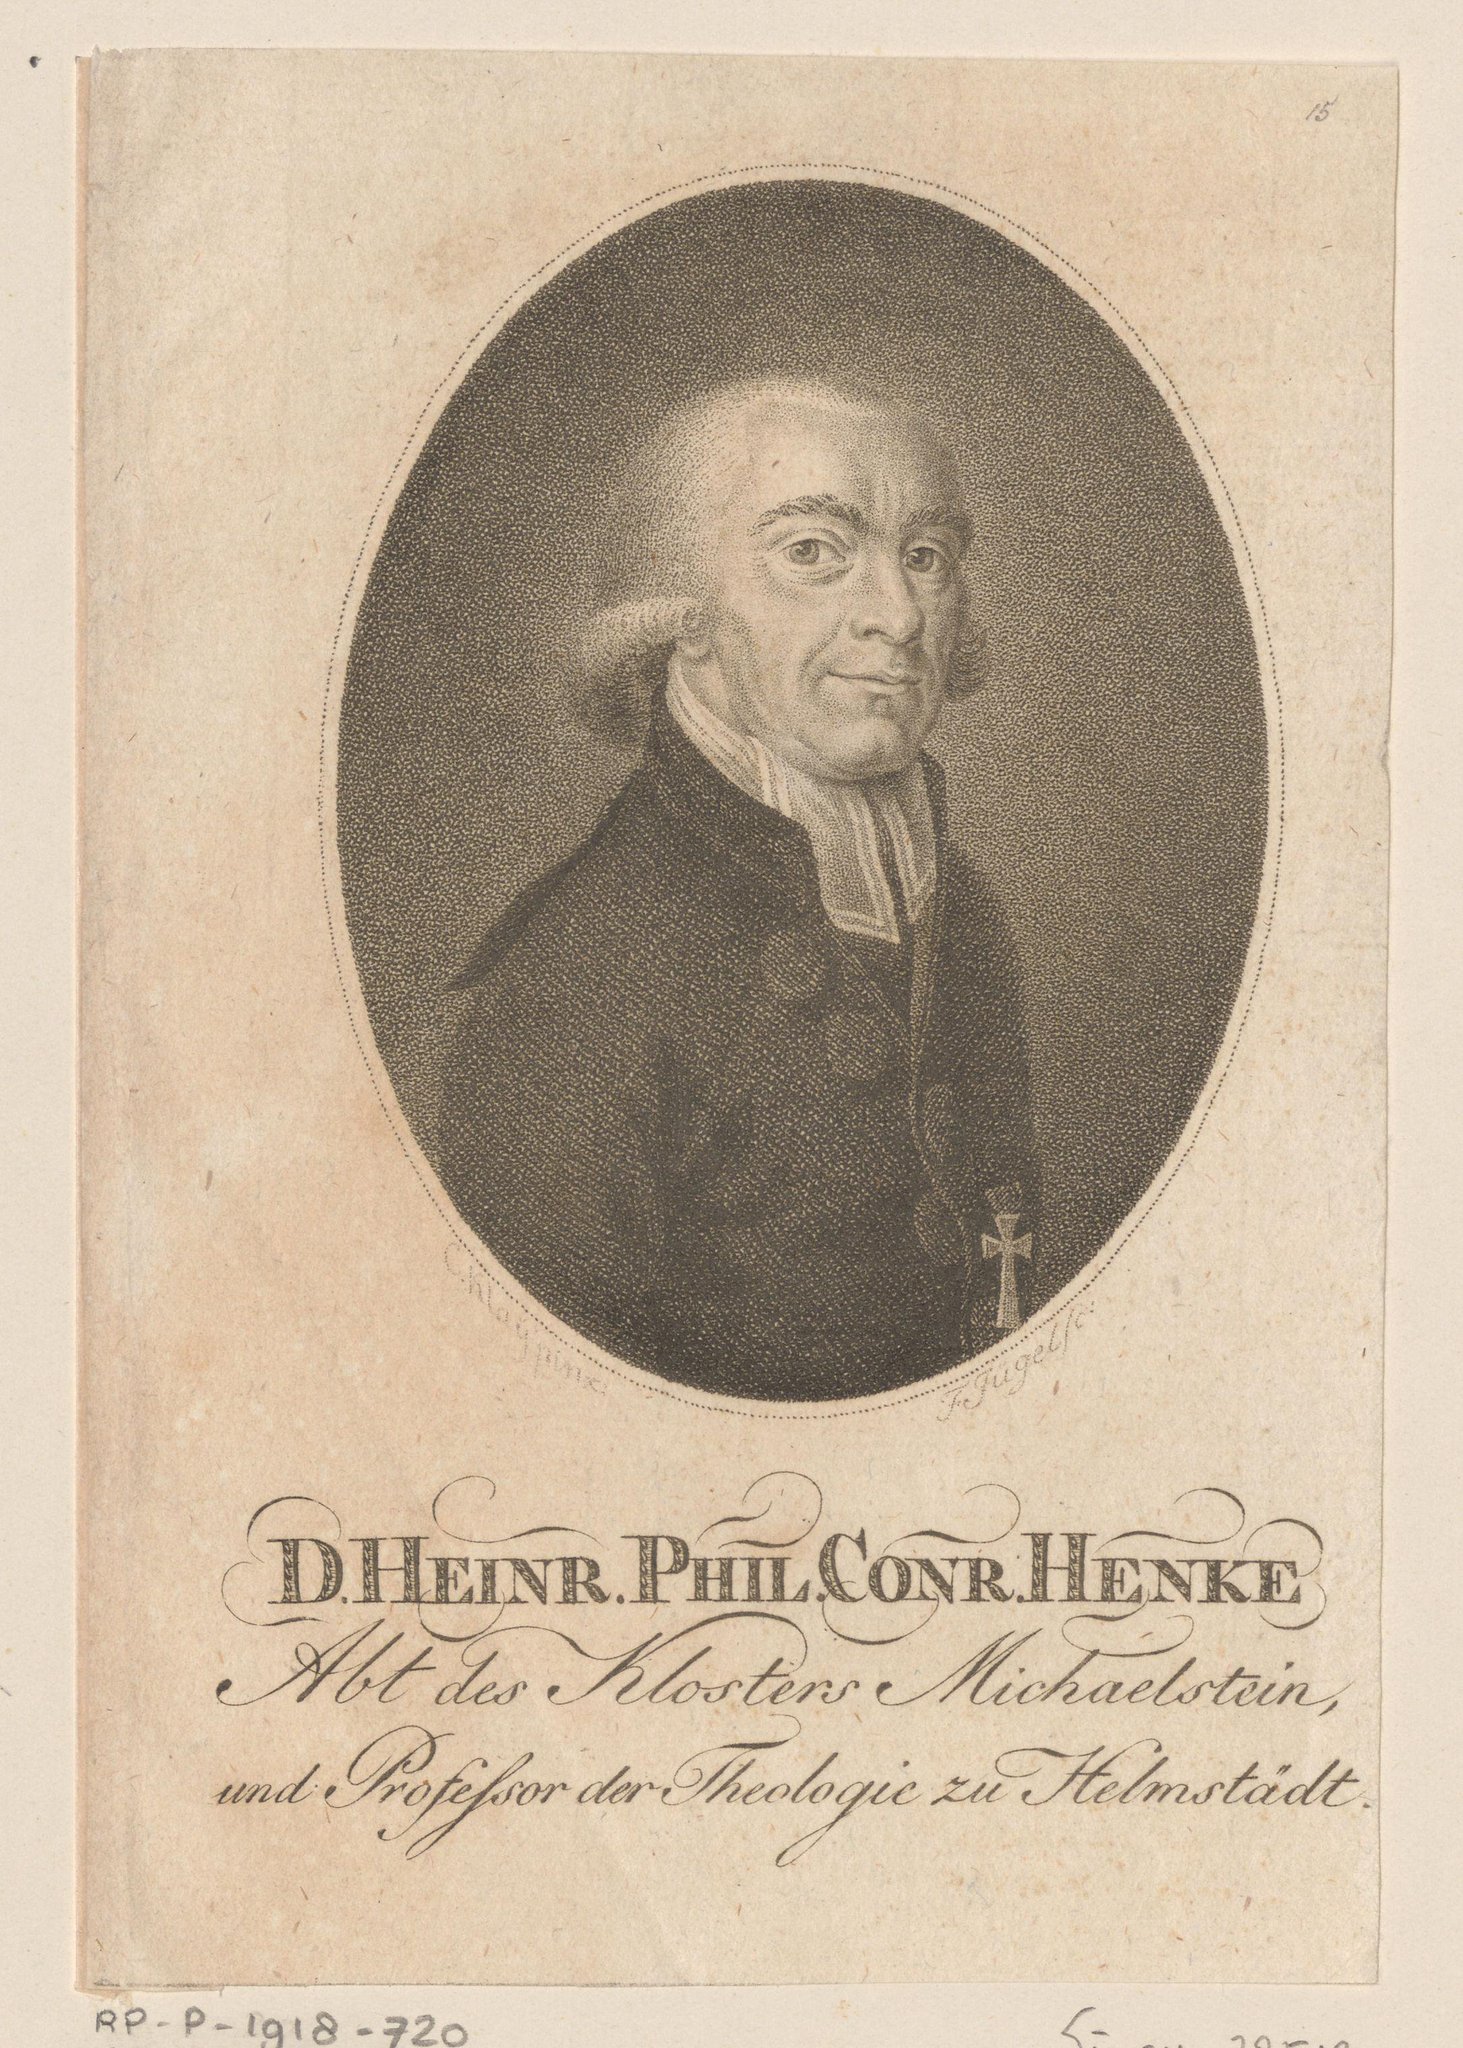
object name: print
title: Portret van Heinrich Philipp Conrad Henke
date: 1786-1833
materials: paper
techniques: engraving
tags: abbot, historical persons, professor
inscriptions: collector's mark: Lugt 2233